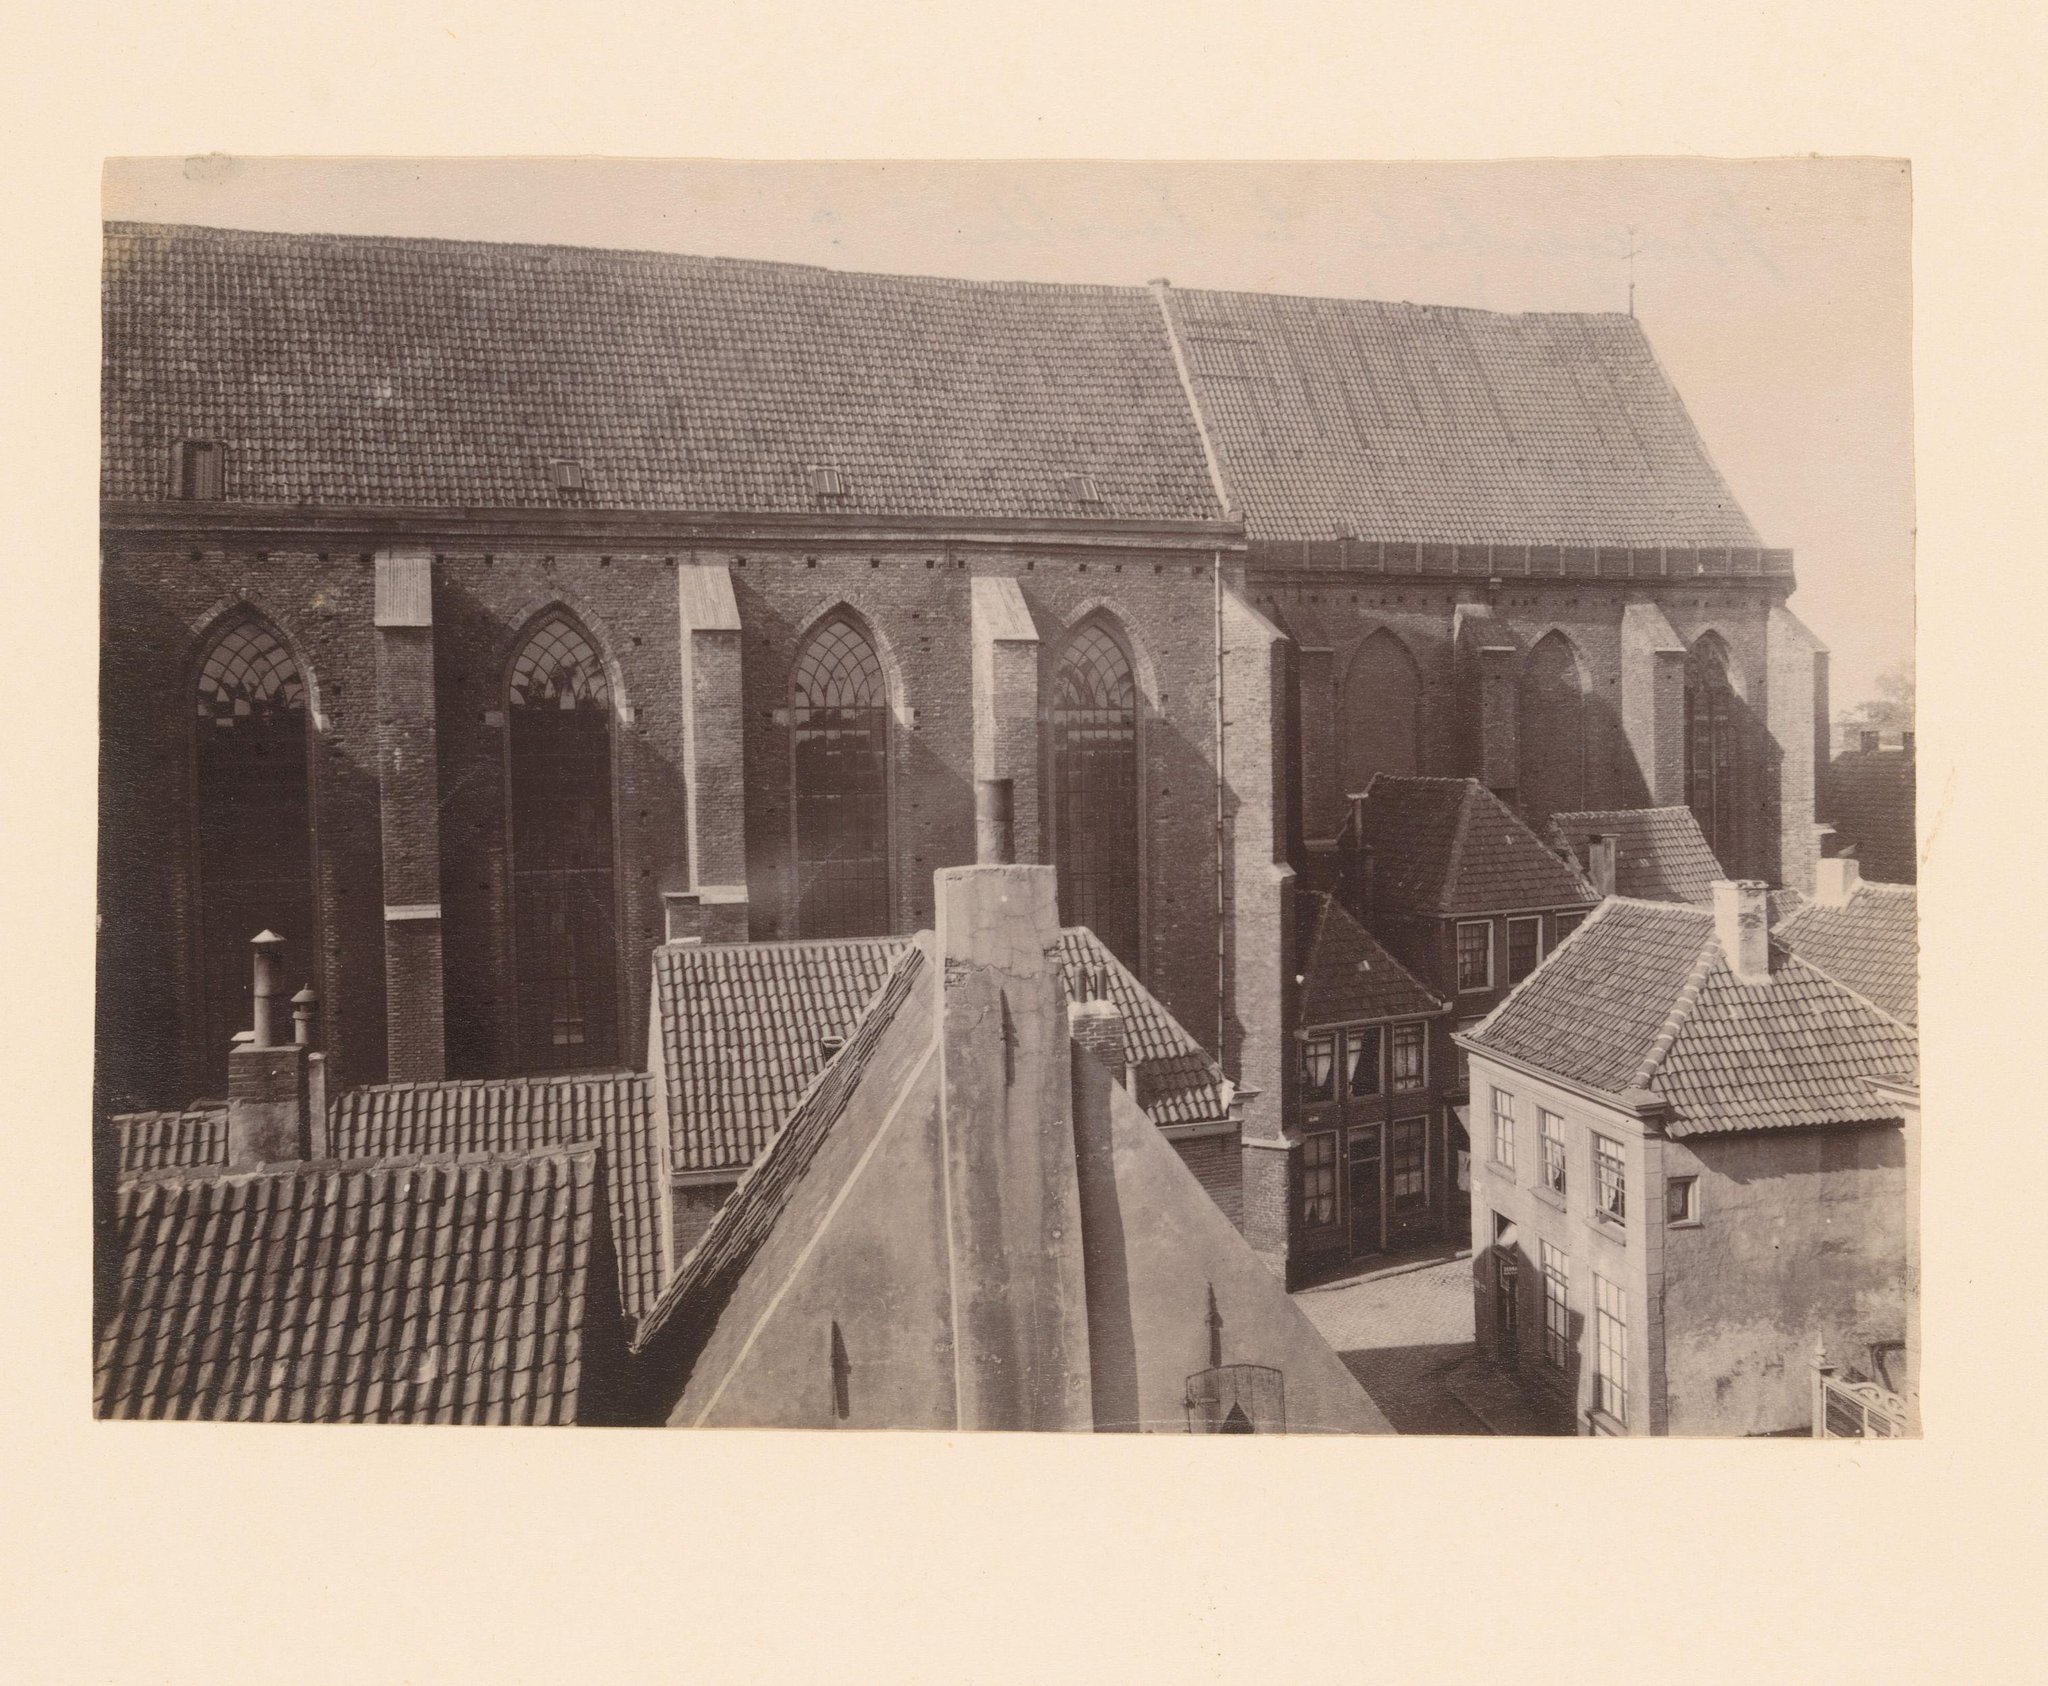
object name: photograph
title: Zuidzijde van de Broerenkerk te Zwolle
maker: anoniem (monumentenzorg)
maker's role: fotograaf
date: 1909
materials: cardboard, photographic support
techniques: albumen print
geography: zwolle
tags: church (exterior)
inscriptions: annotation: ‘Broerenkerk/ Zwolle’, annotation: ‘Broerenkerk te Zwolle/ Zuidzijde/ juni 1909’